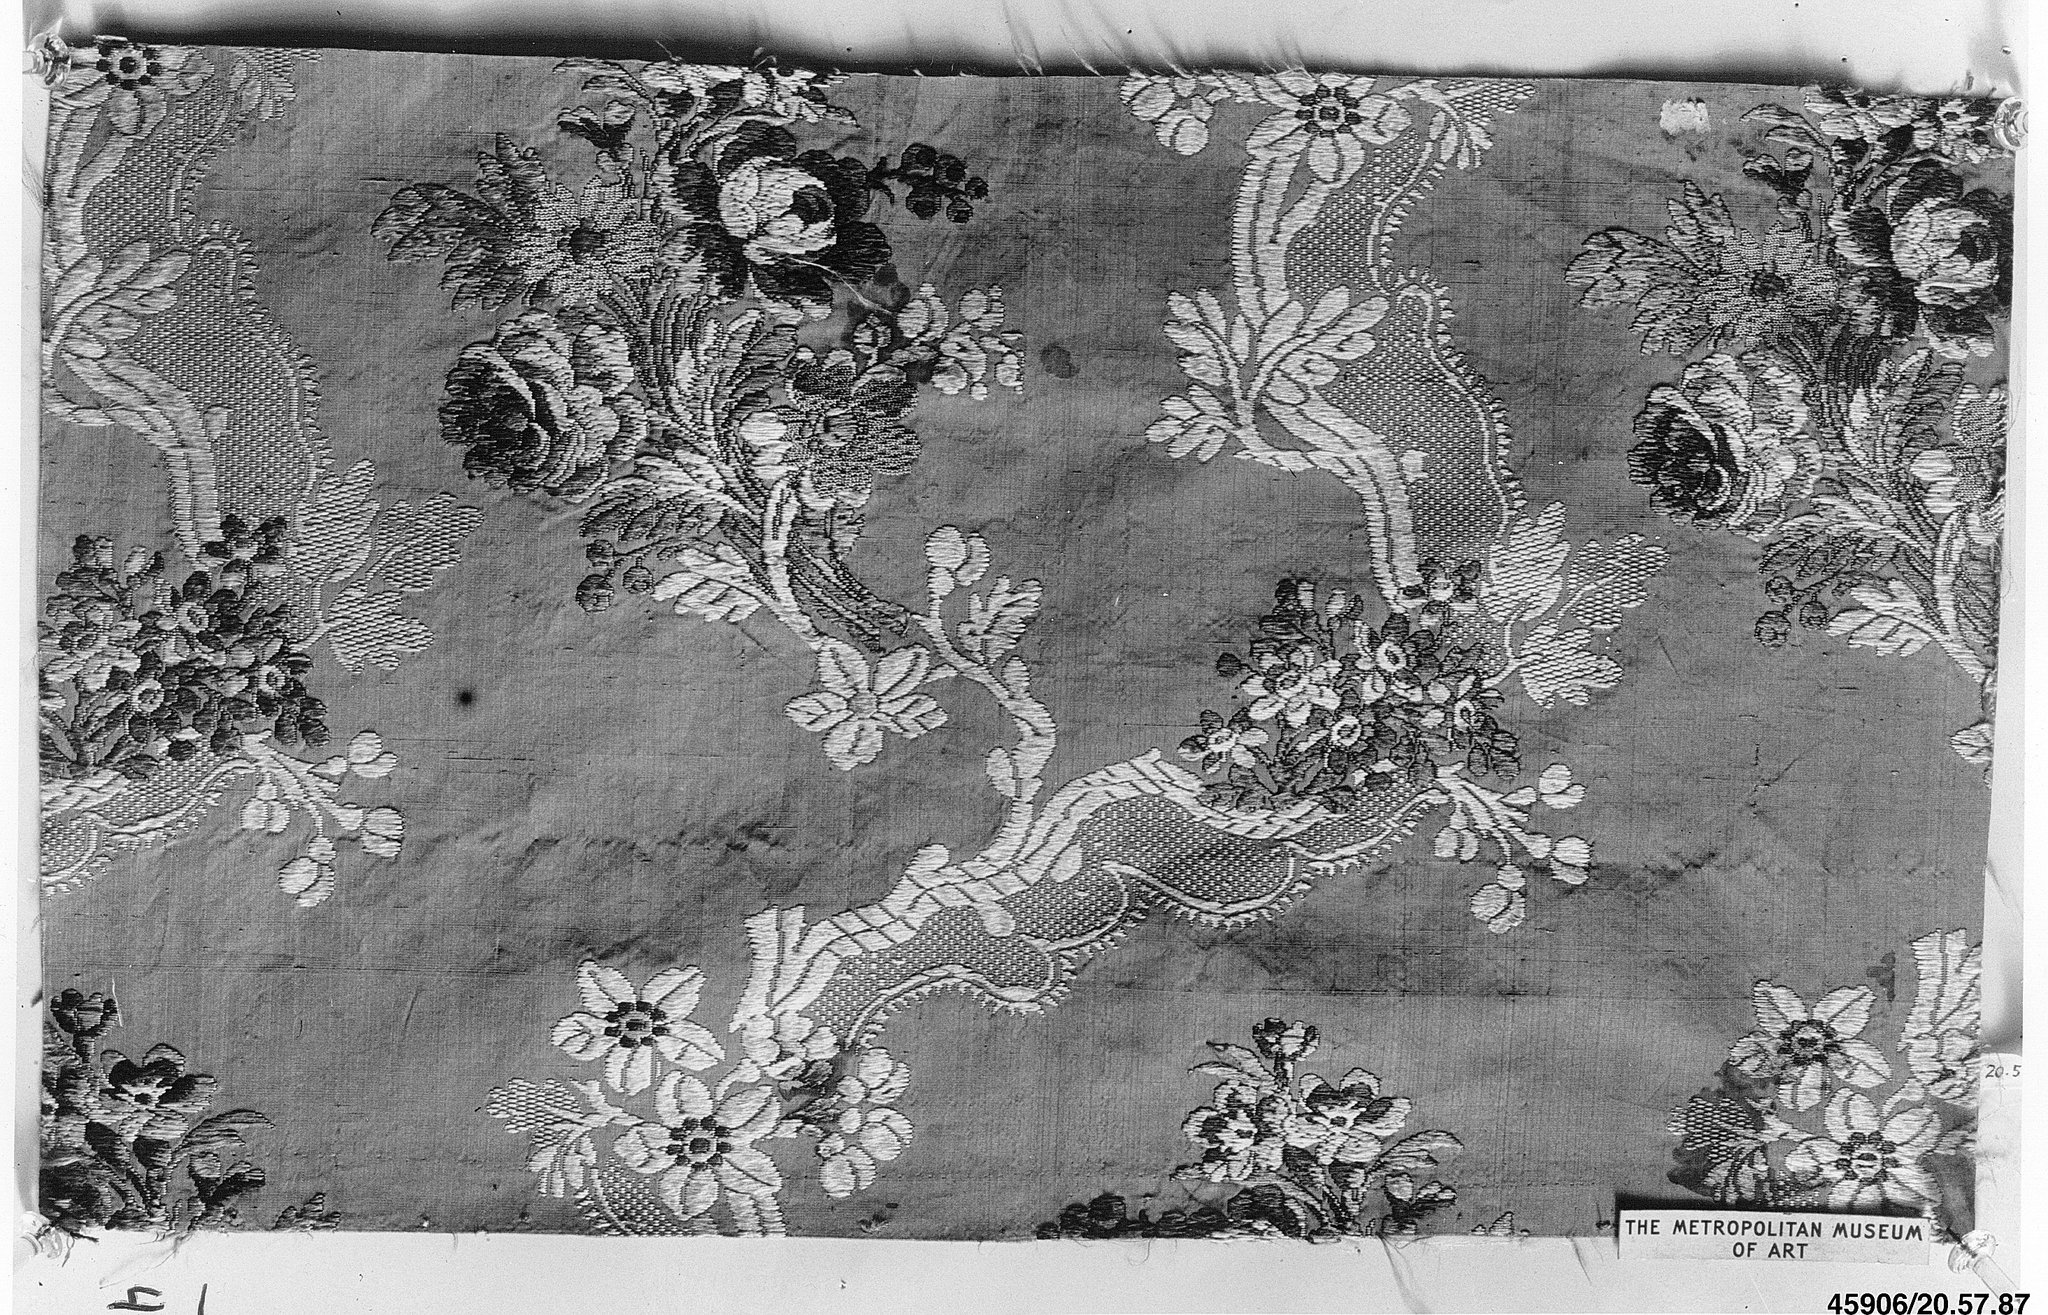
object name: piece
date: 1750-1760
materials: silk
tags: flowers,leaves